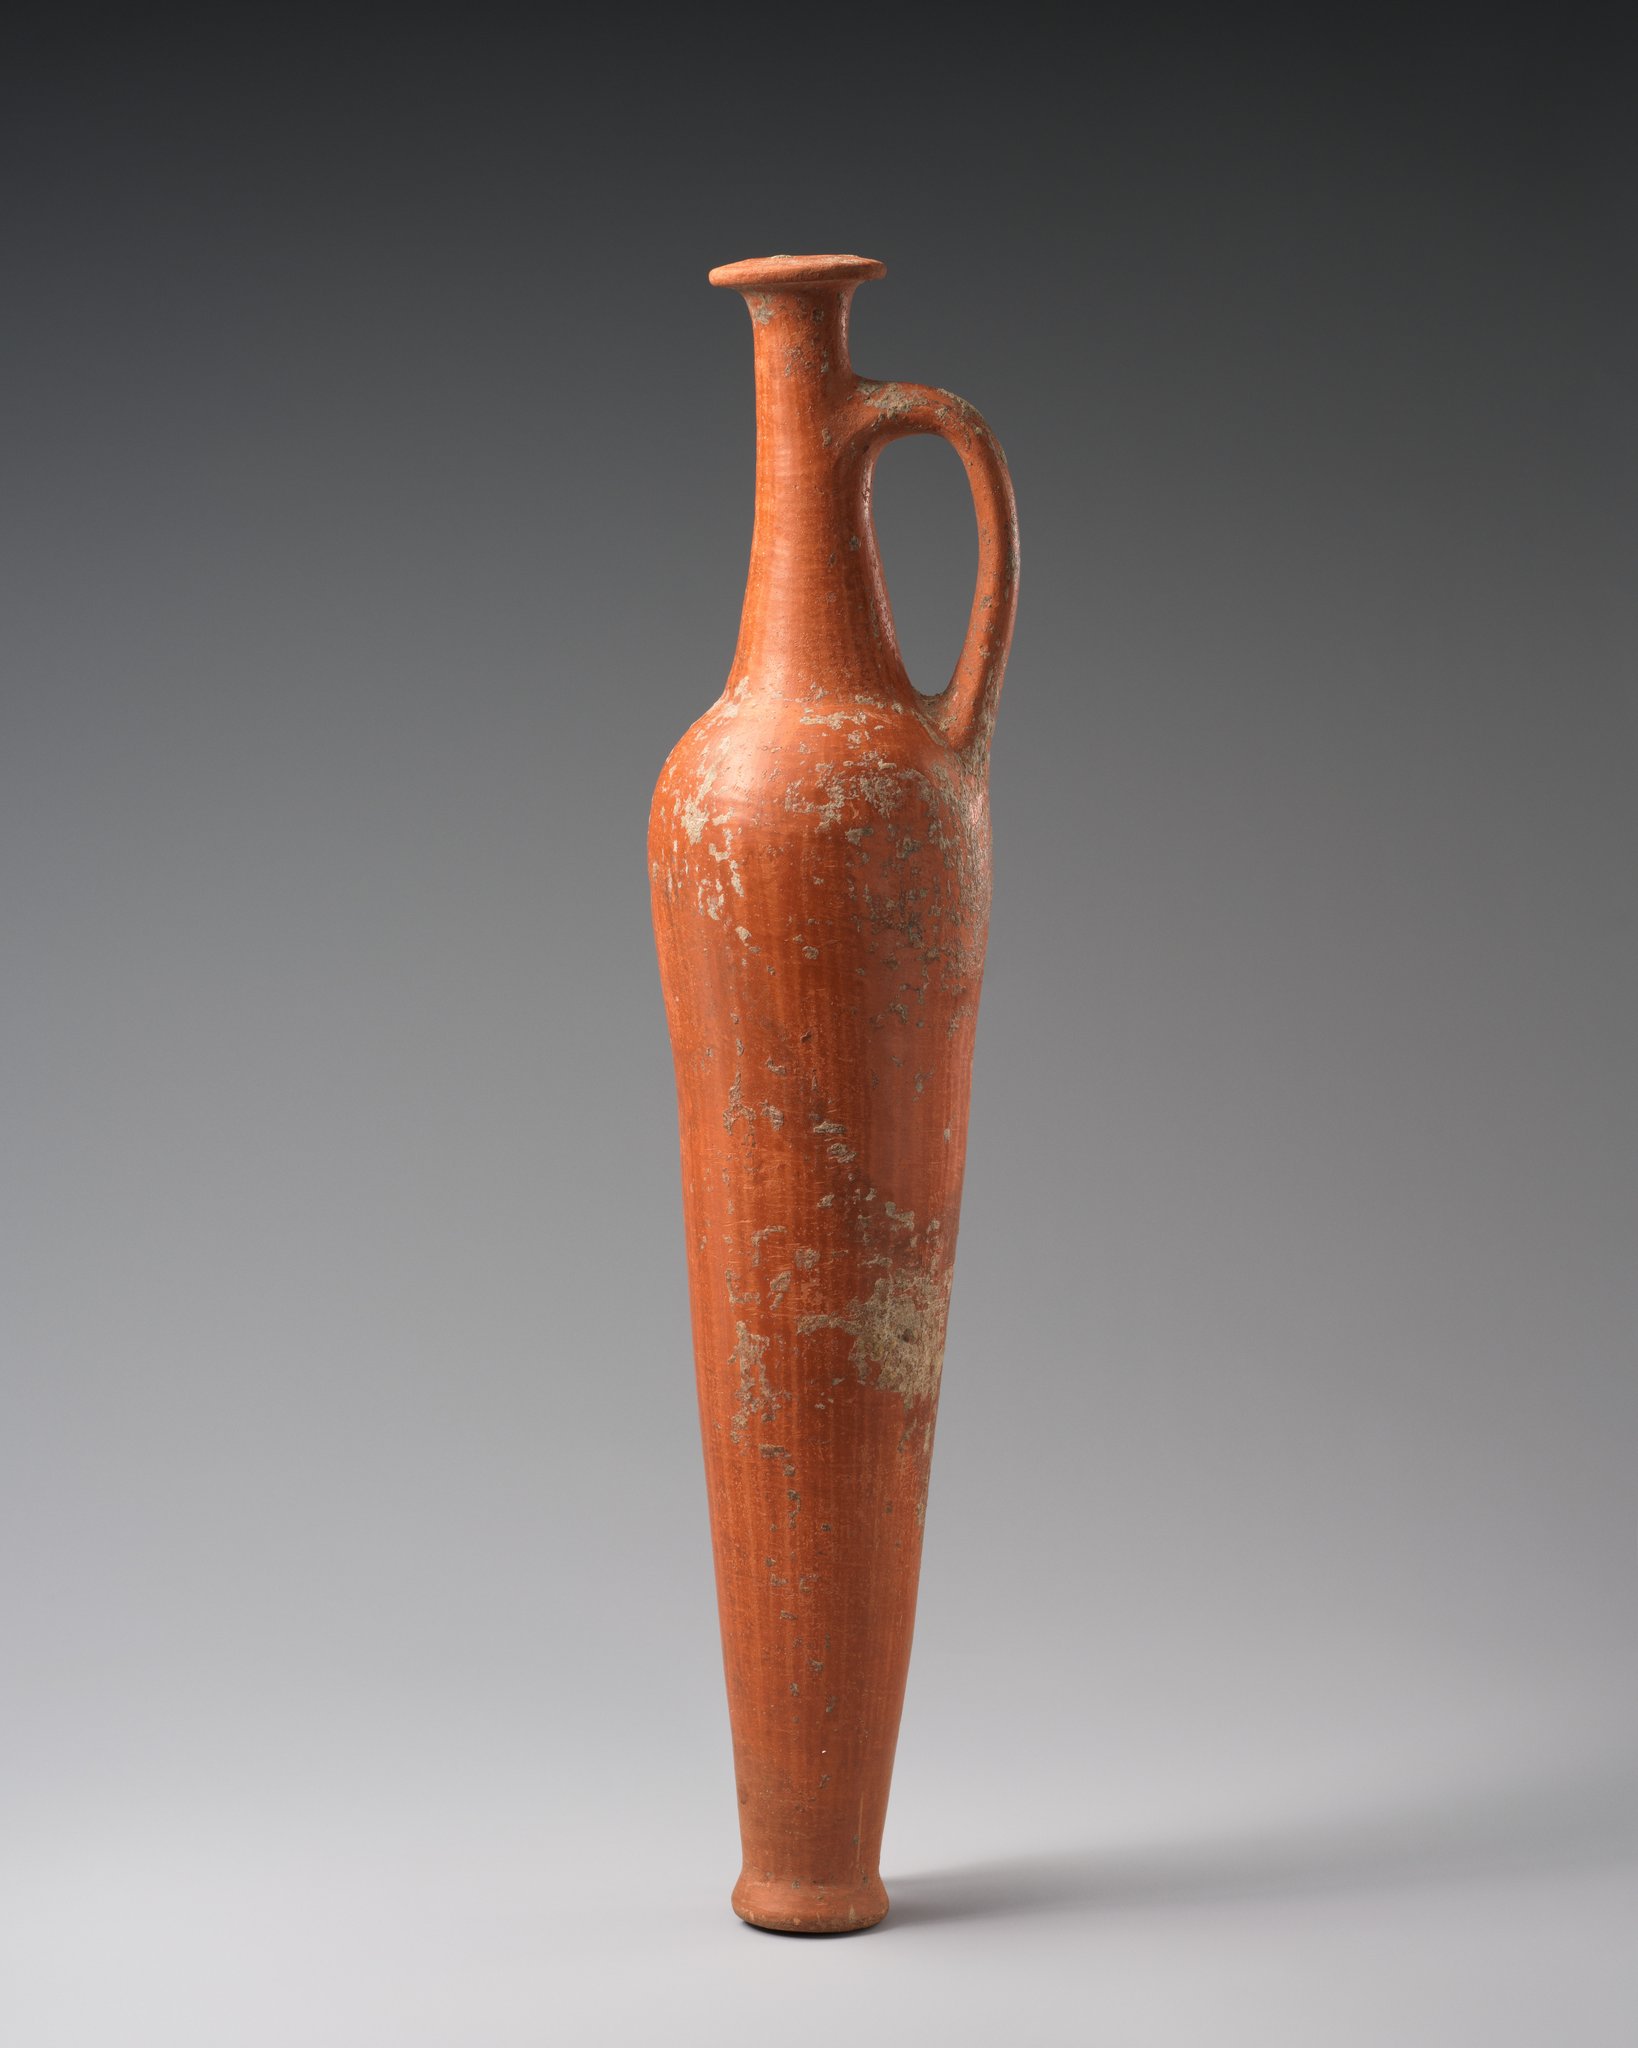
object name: spindle bottle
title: Terracotta spindle bottle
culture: cypriot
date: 1600-1050 BCE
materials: terracotta